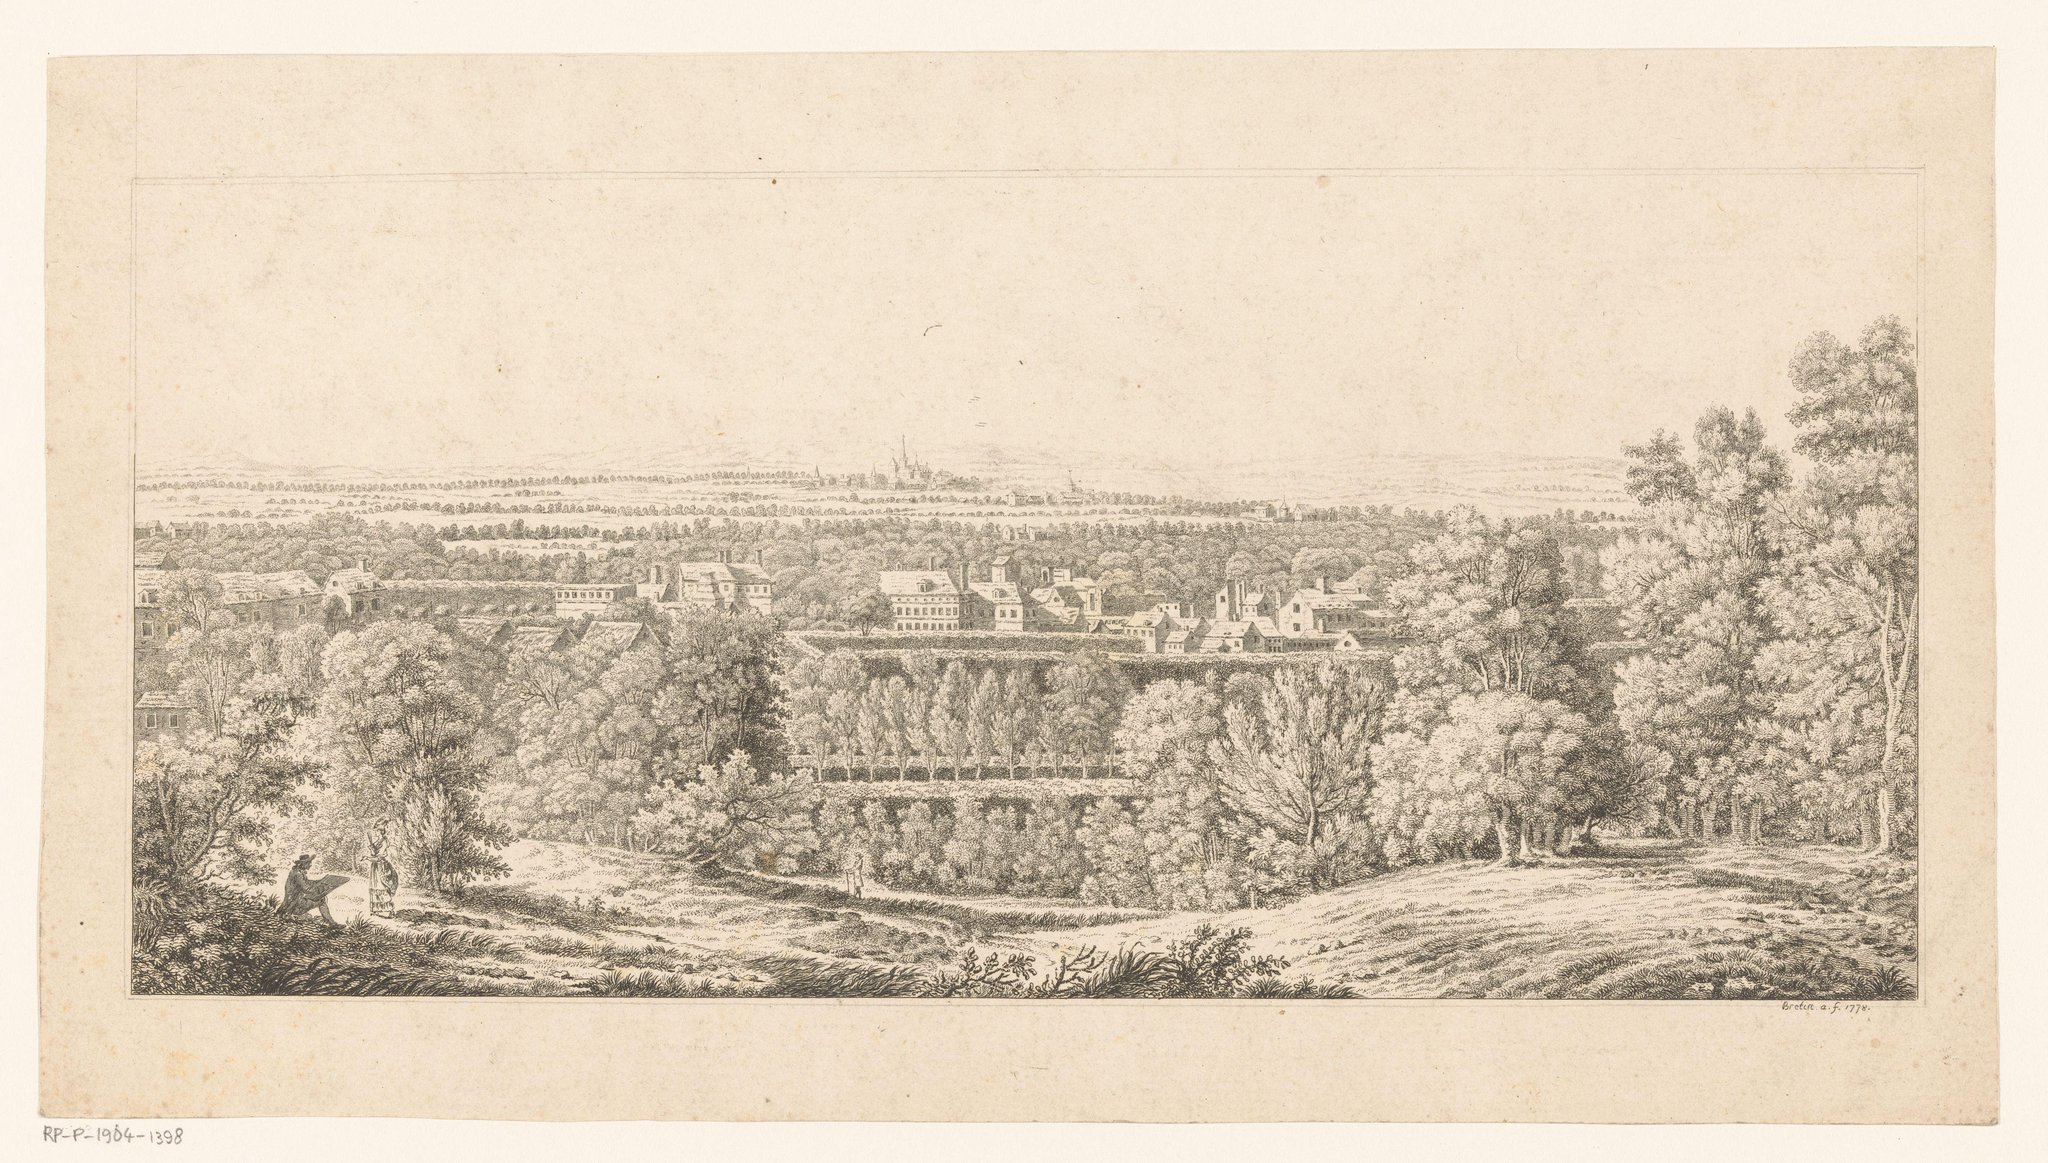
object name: print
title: Wandspiegels met tafels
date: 1758-1820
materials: paper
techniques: engraving, etching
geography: ravensburg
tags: mirror, hunting trophies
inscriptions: collector's mark: Lugt 2228, collector's mark: Lugt 2760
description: Ontwerp voor een wandspiegel met een tafel, gedecoreerd met guirlandes en een jachttrofee.. Links en rechts een wand met panelen. Uitgeversnummer XXIV.